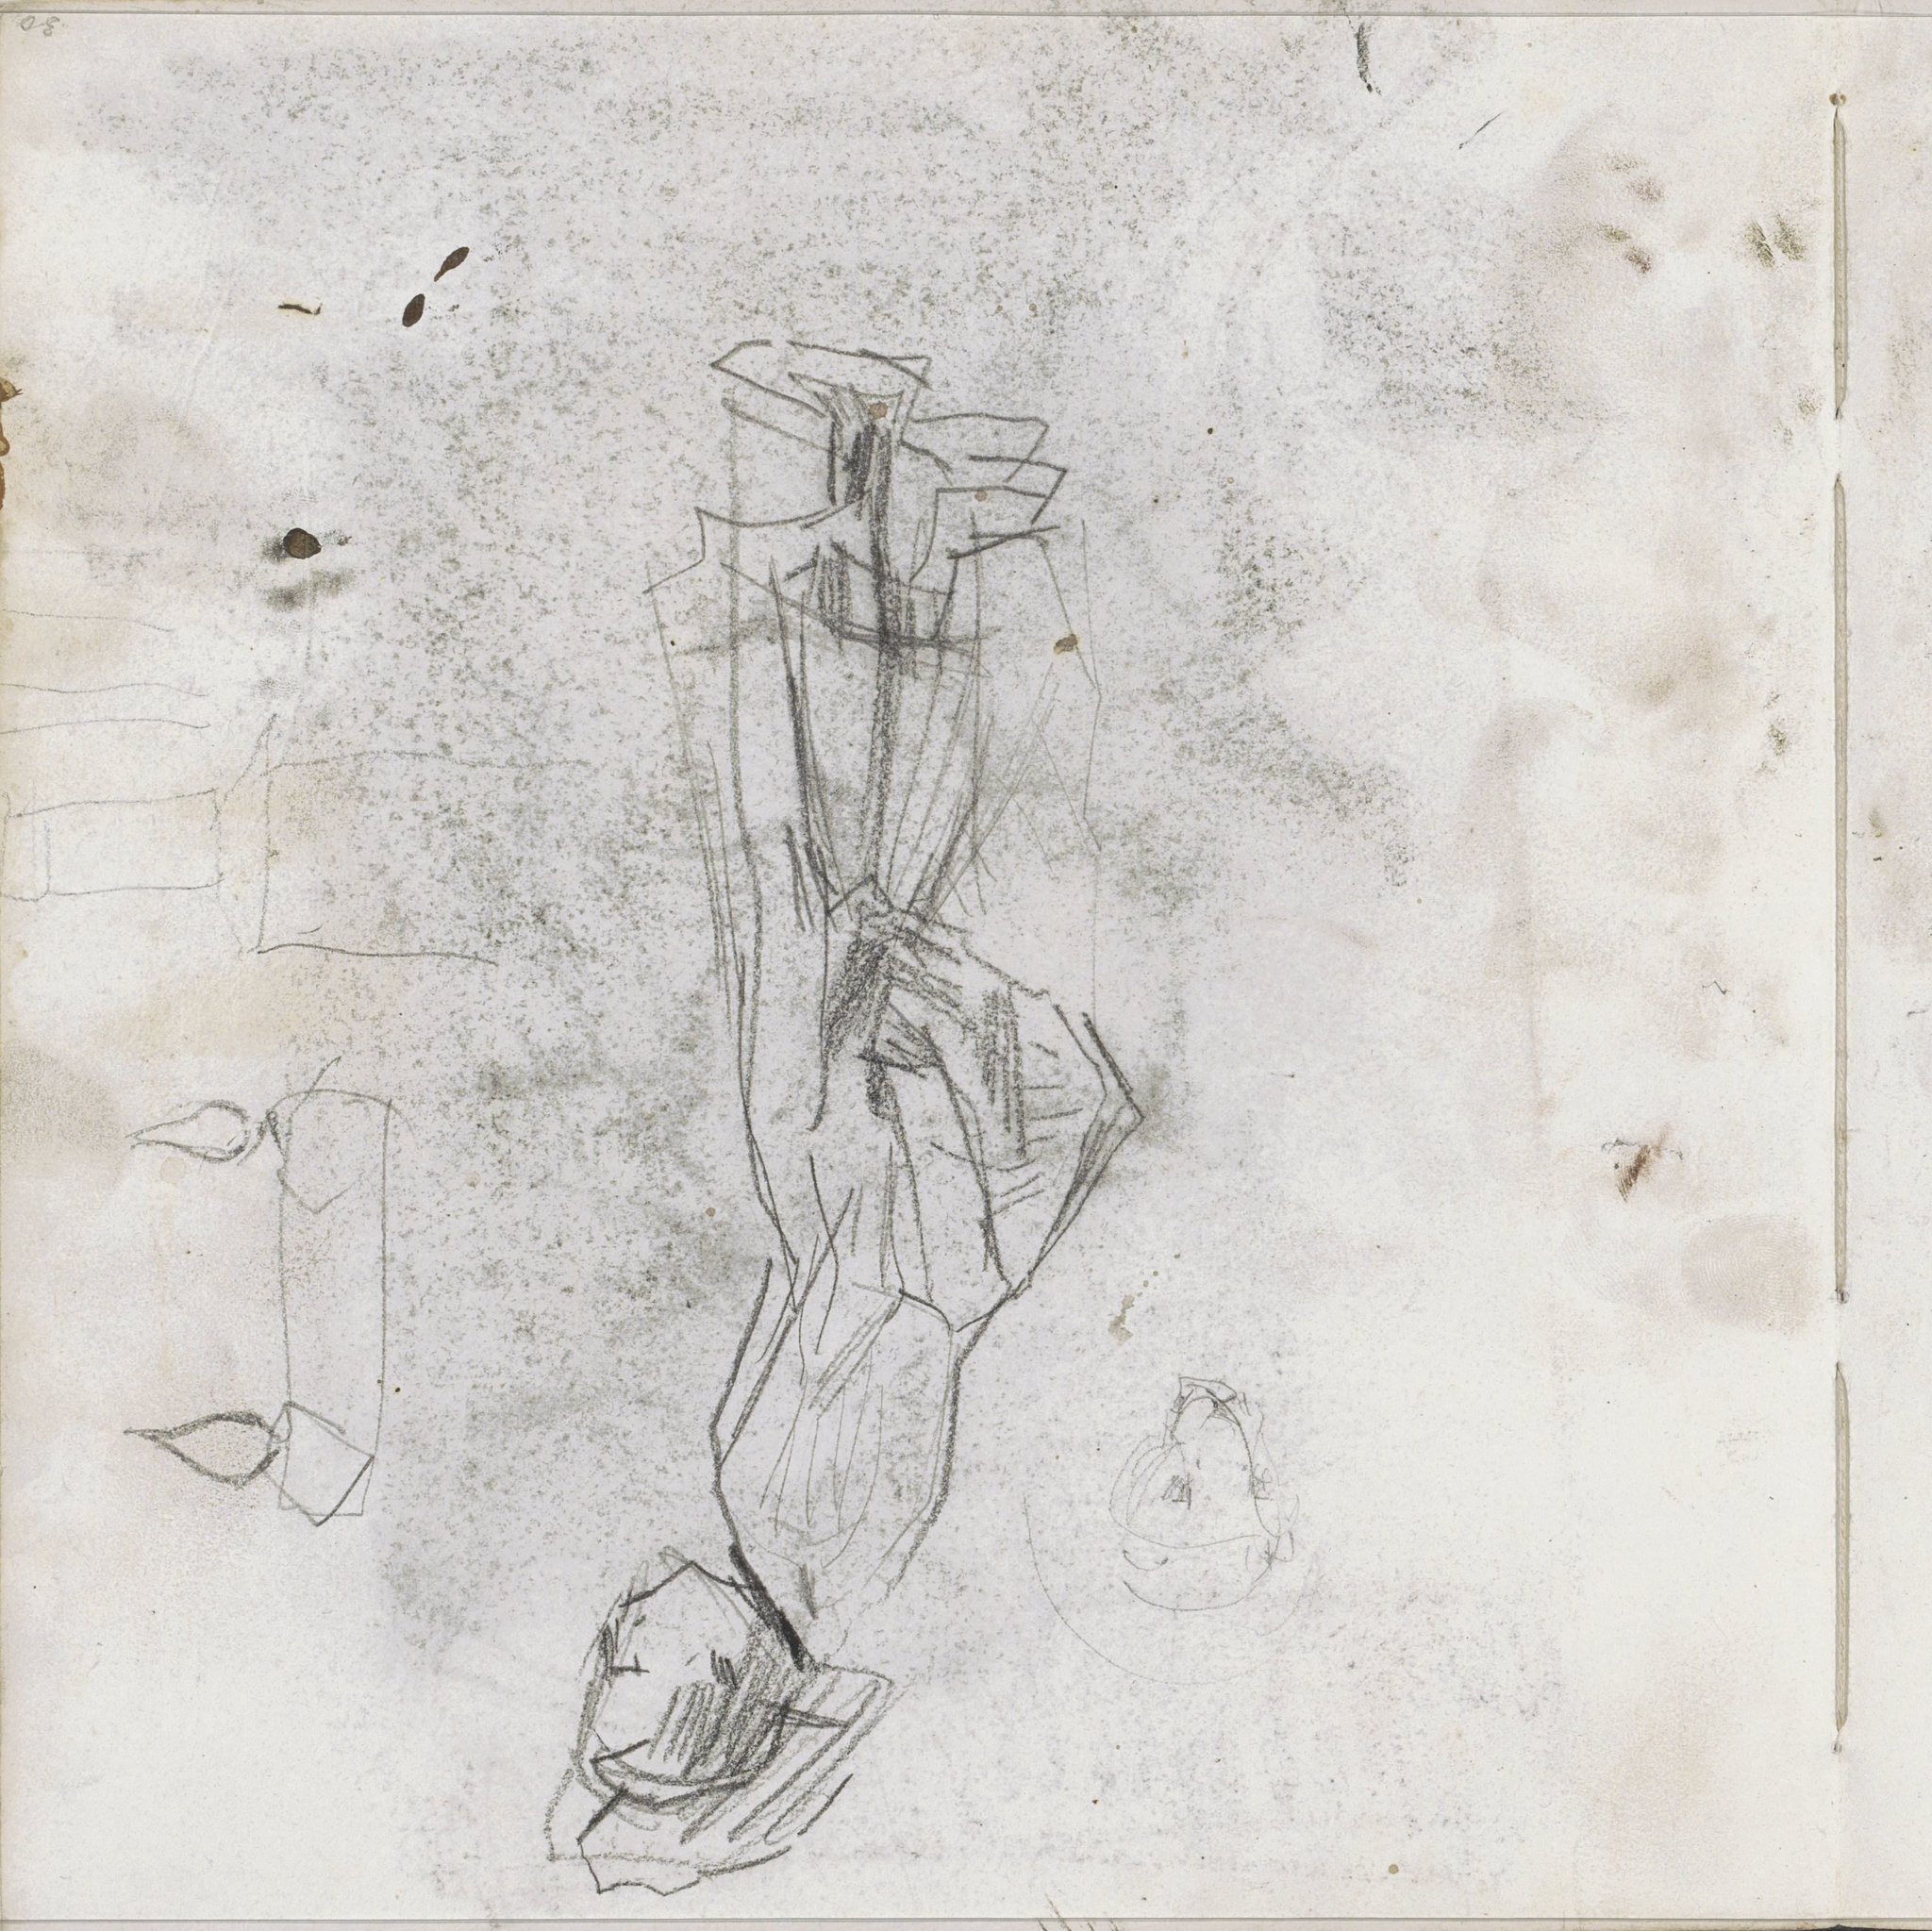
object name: sketchbook leaf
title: Staande vrouw, in profiel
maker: isaac israels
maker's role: draughtsman, painter, print maker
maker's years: 1865-1934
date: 1875-1934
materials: chalk, paper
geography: the hague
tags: adult woman (+ standing), beasts of prey, predatory animals: lion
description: Ernaast mogelijk een leeuwenkop. Blad 27 verso uit schetsboek IX met 28 bladen.